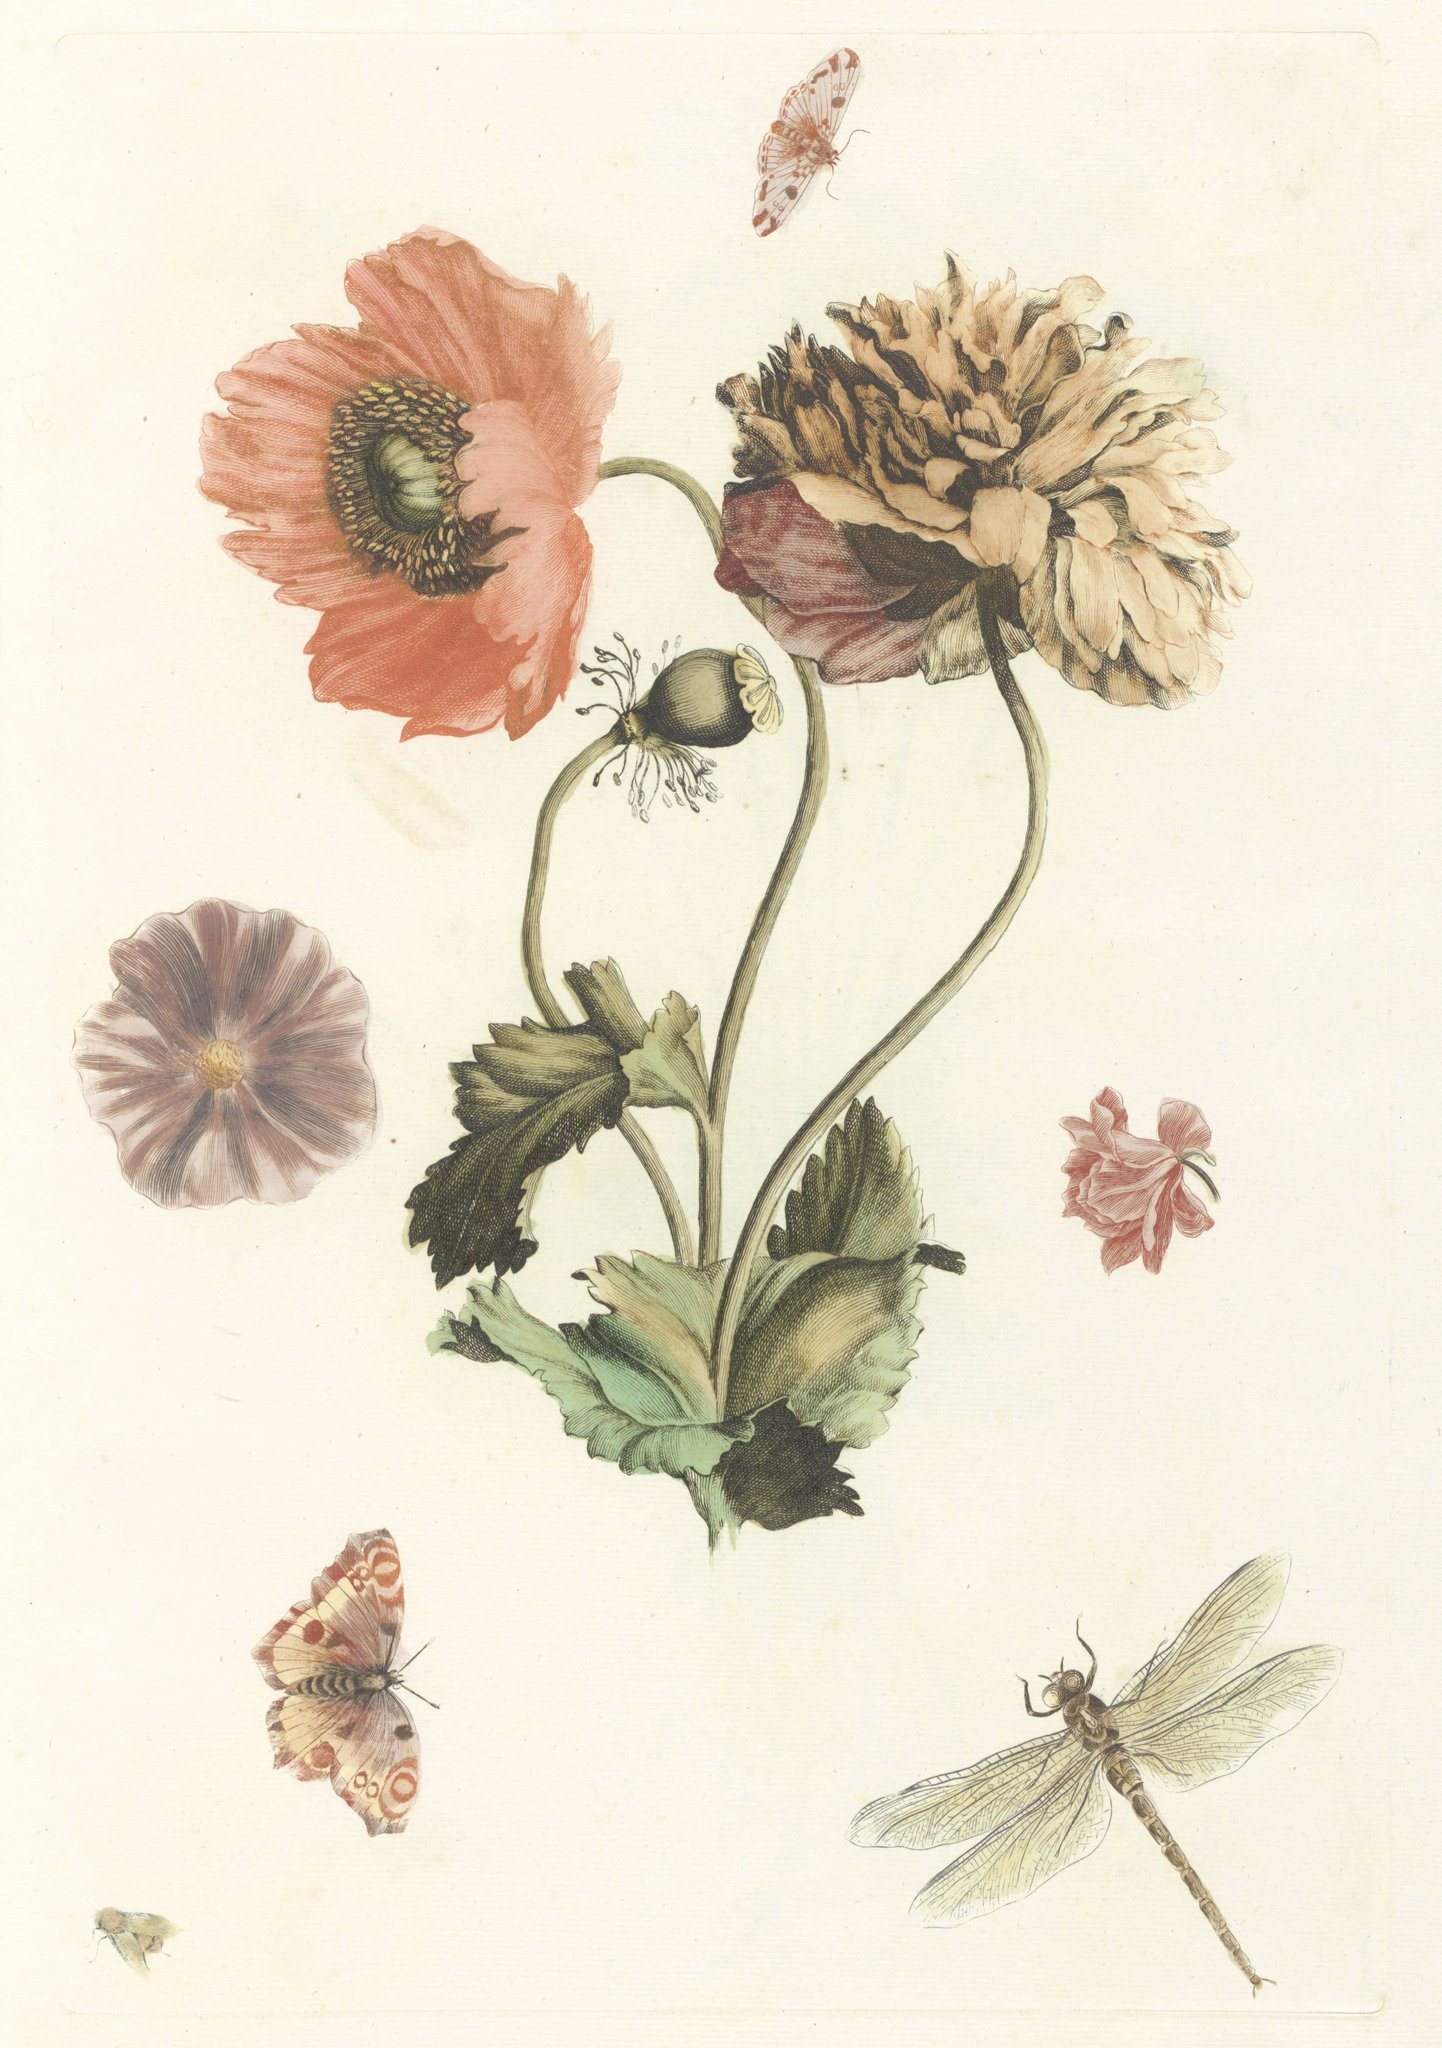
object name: album leaf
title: Drie papavers, twee vlinders, een vlieg en een libelle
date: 1688-1698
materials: paper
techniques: printing, engraving, hand coloring, lithography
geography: netherlands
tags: insects: dragon-fly, insects: butterfly, flowers: poppy, insects: fly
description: Deze prent maakt deel uit van een album.